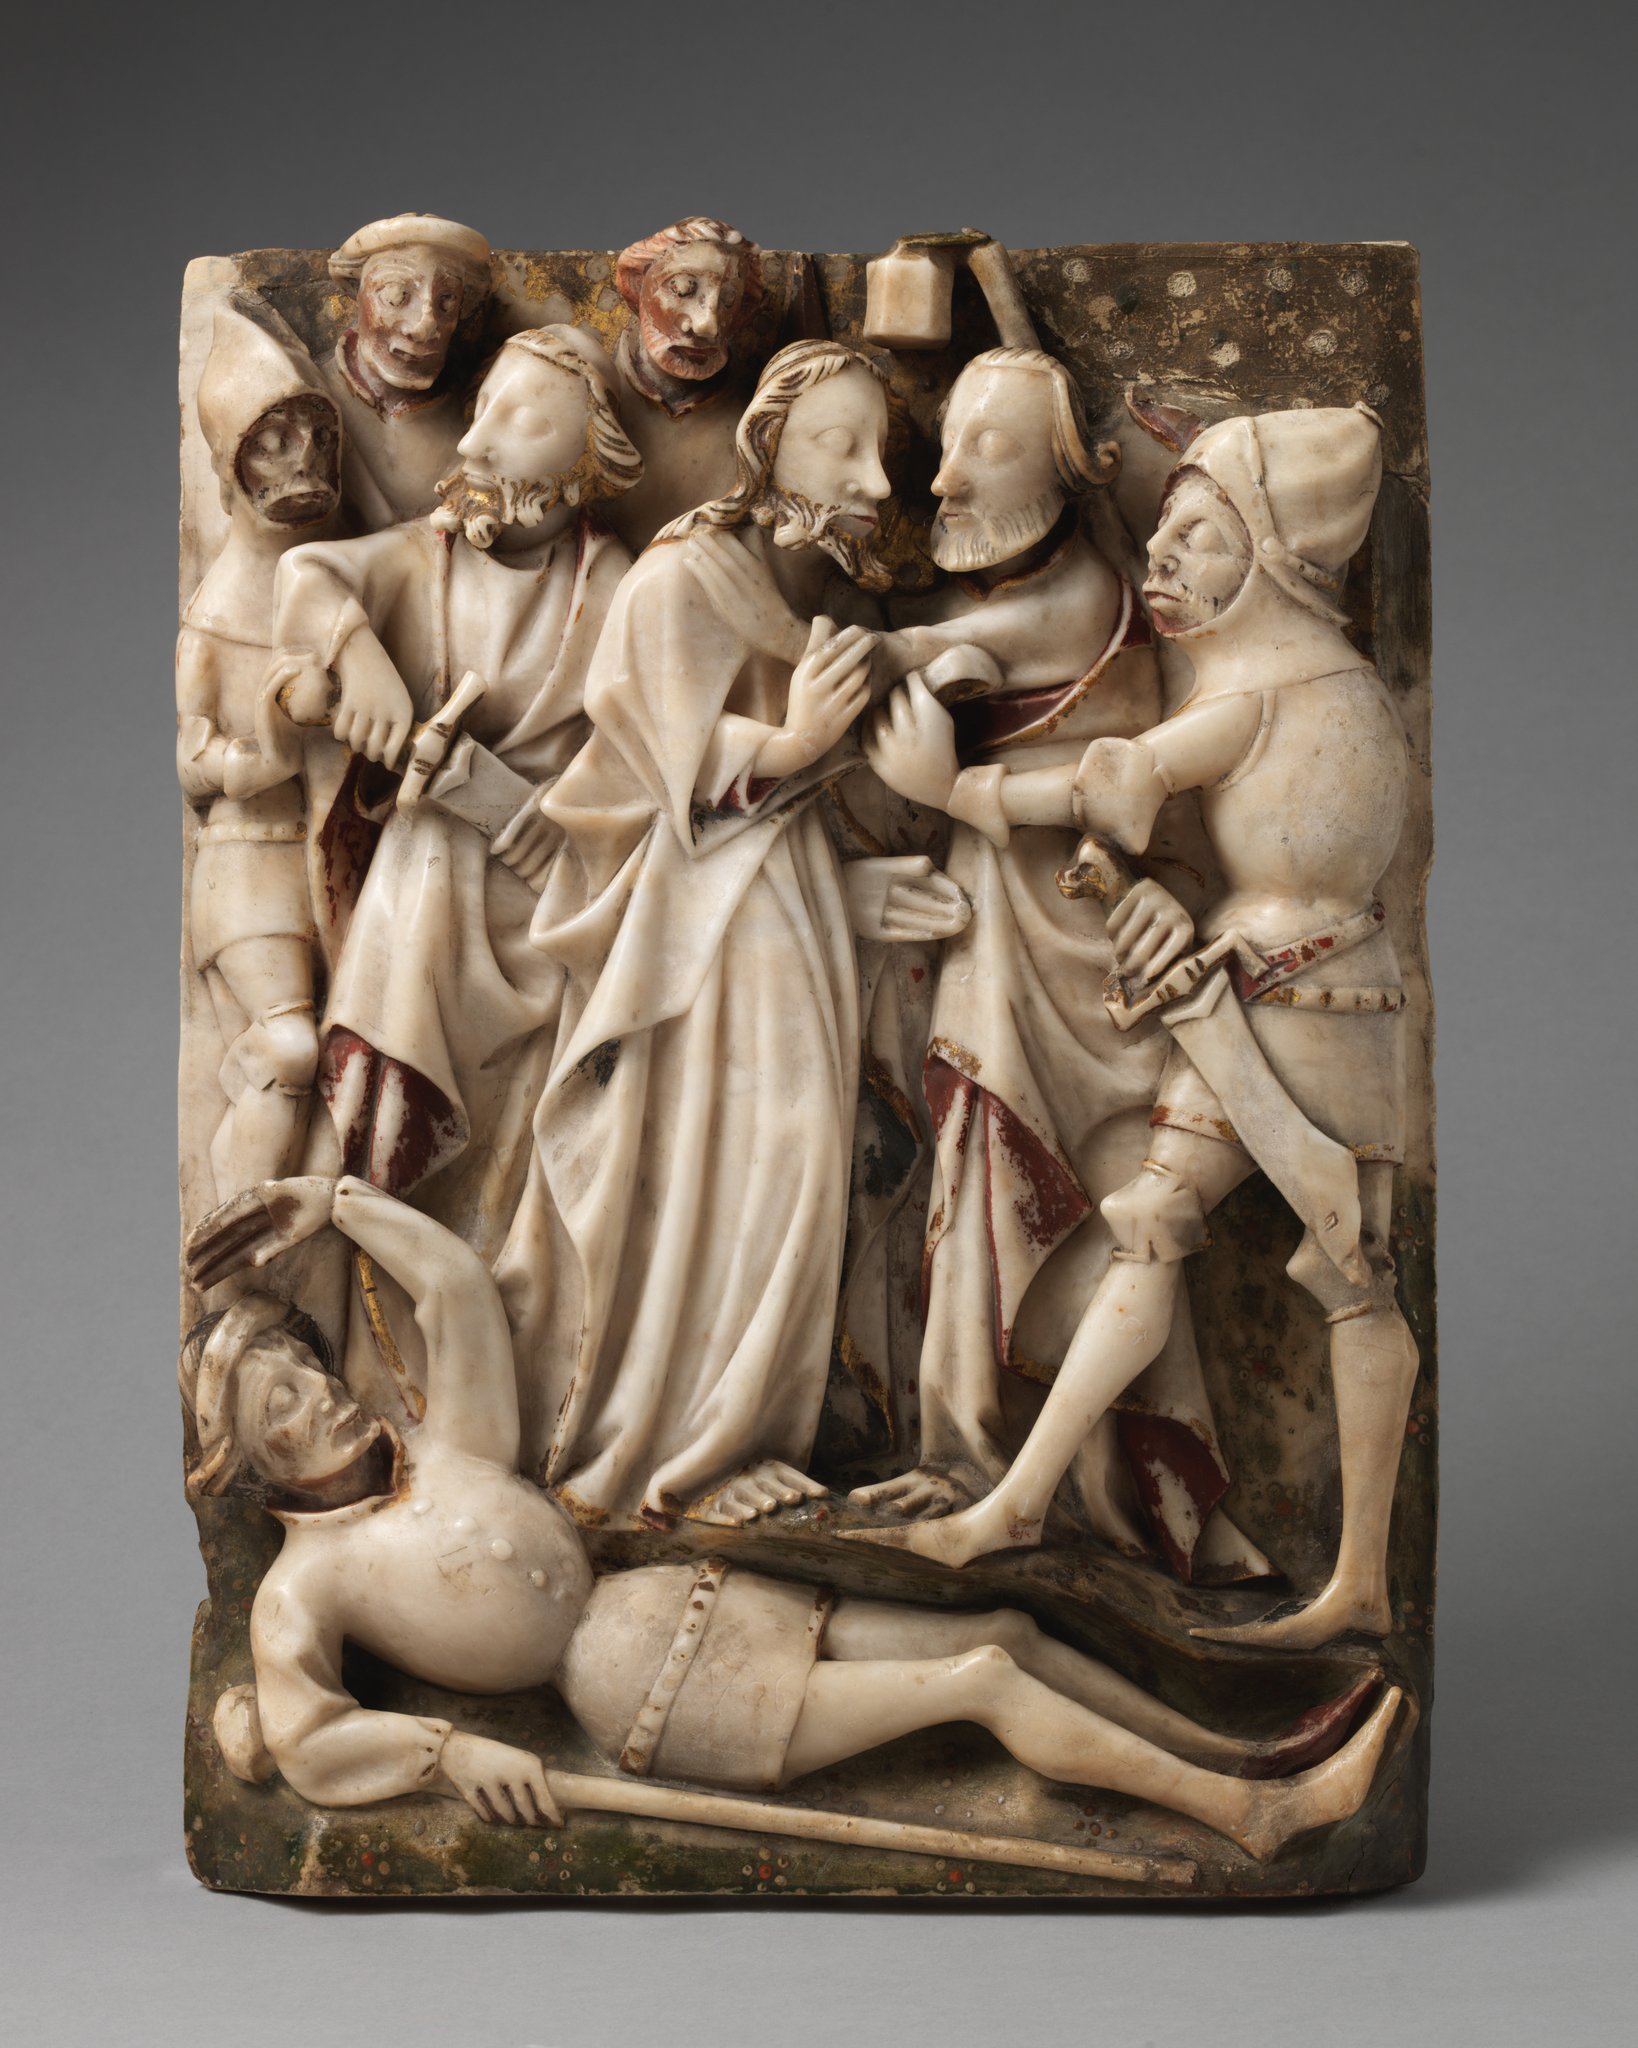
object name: plaque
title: The Betrayal of Christ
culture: british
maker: school of nottingham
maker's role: artist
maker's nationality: british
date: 1401-1500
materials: alabaster, paint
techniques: gilding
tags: soldiers,men,christ,judas